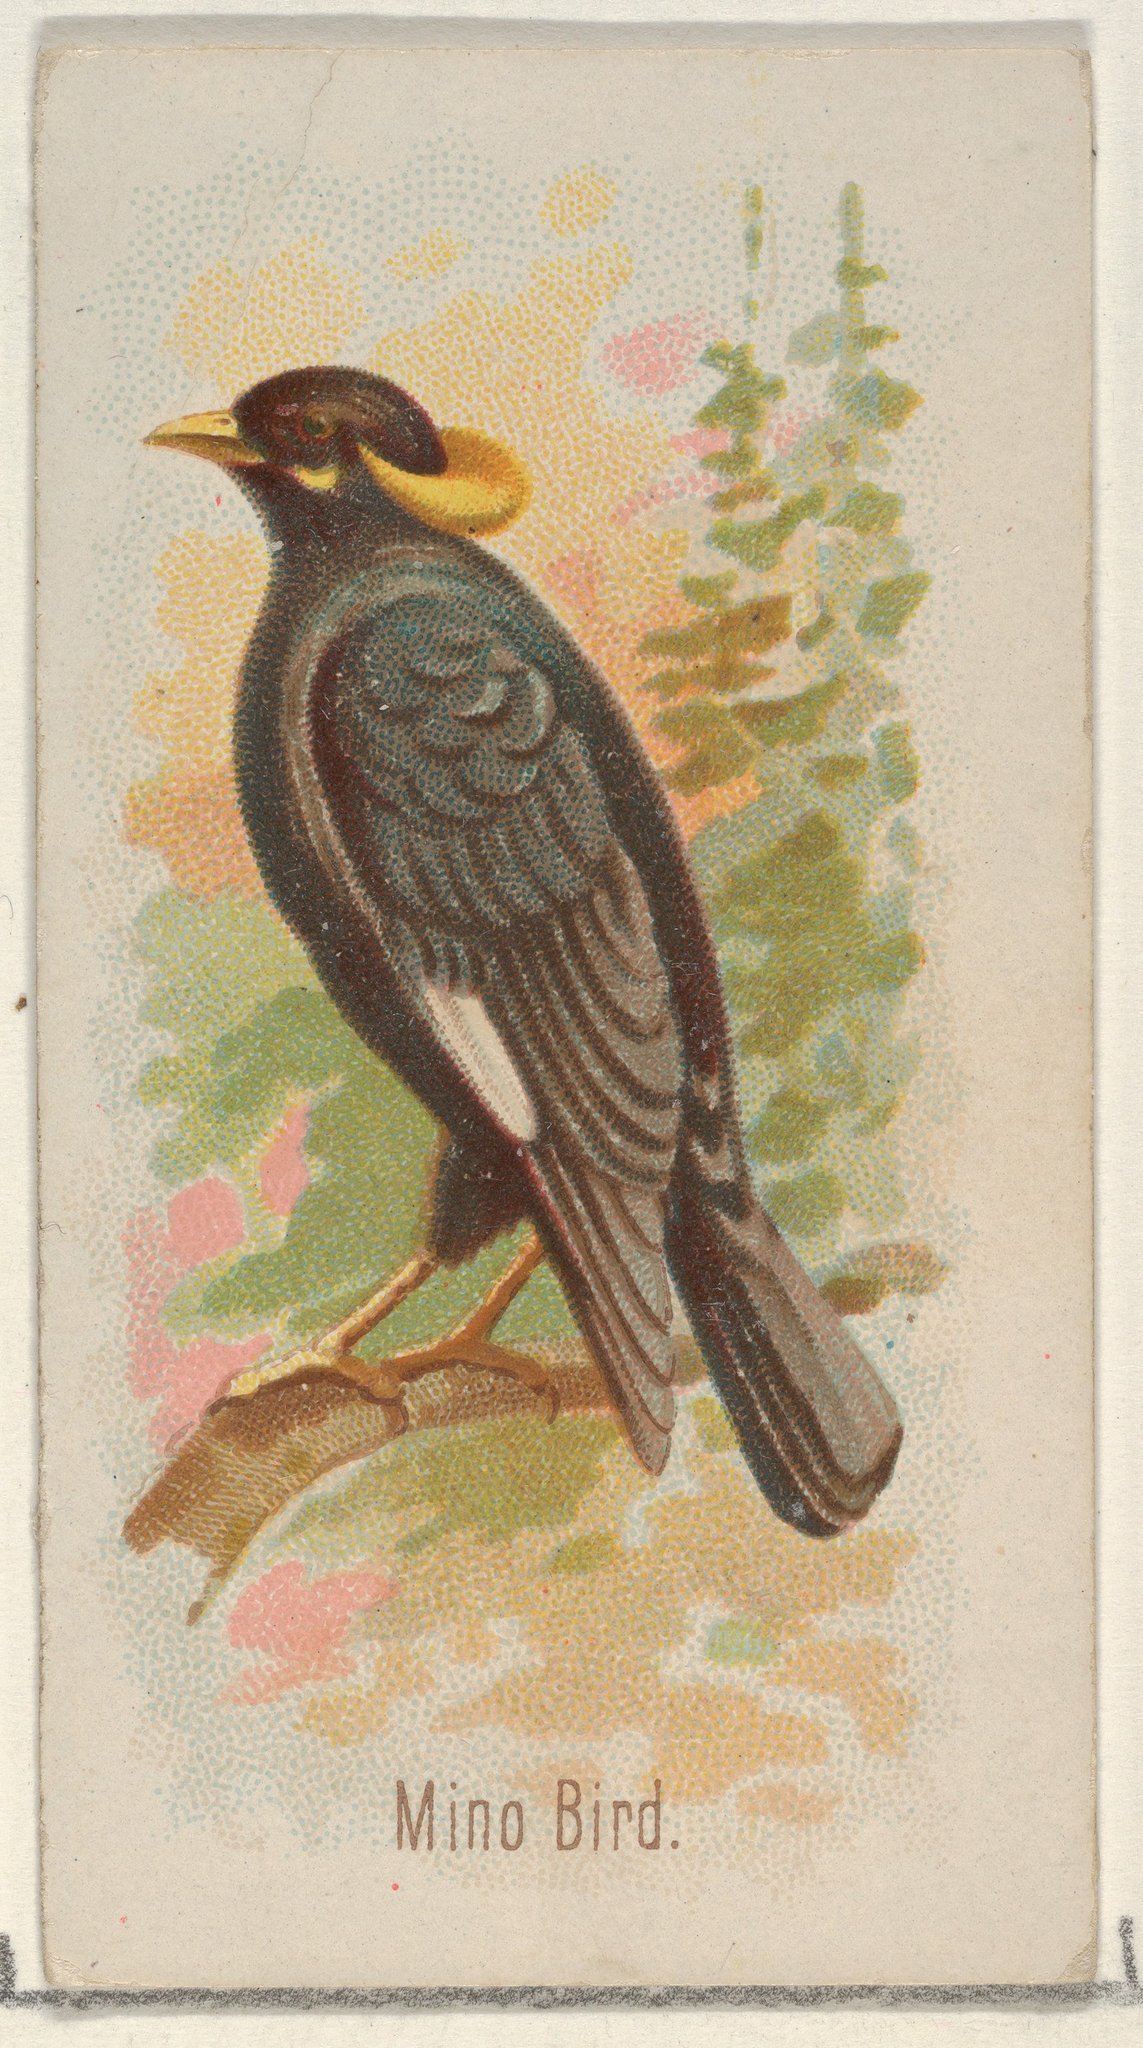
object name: print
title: Mino Bird, from the Song Birds of the World series (N23) for Allen & Ginter Cigarettes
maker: allen & ginter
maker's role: publisher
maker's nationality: american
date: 1890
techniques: color lithograph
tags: birds